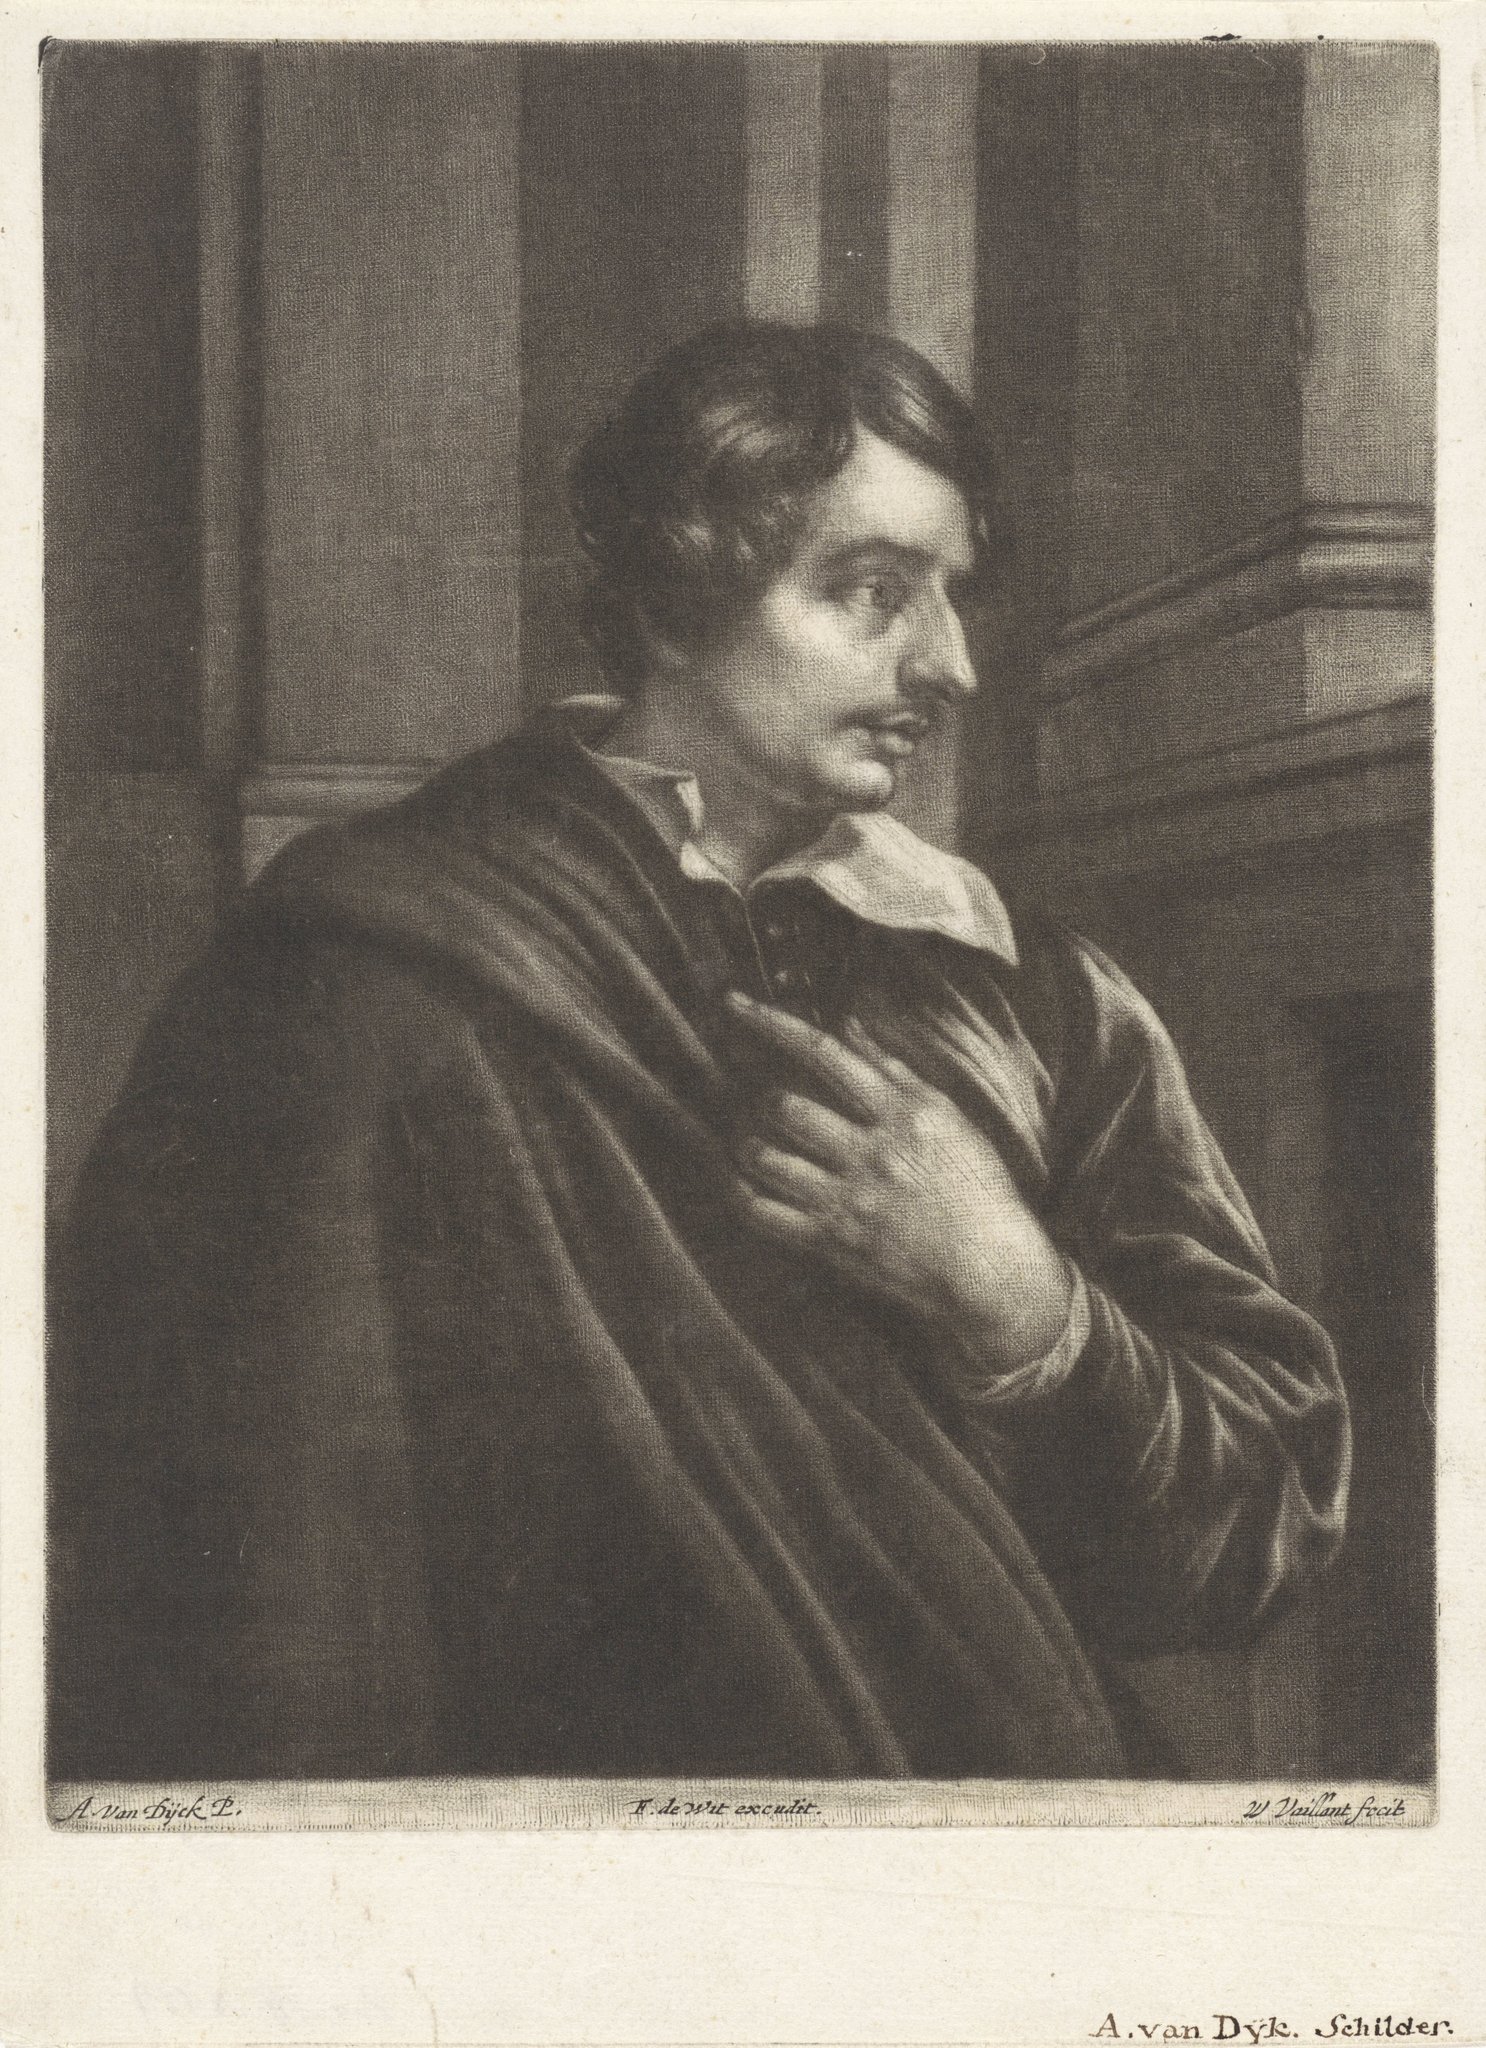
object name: print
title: Portret van een man, mogelijk Jean Leclerc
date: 1658-1677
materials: paper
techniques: mezzotint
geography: amsterdam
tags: print maker, jean leclerc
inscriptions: collector's mark: Lugt 2228